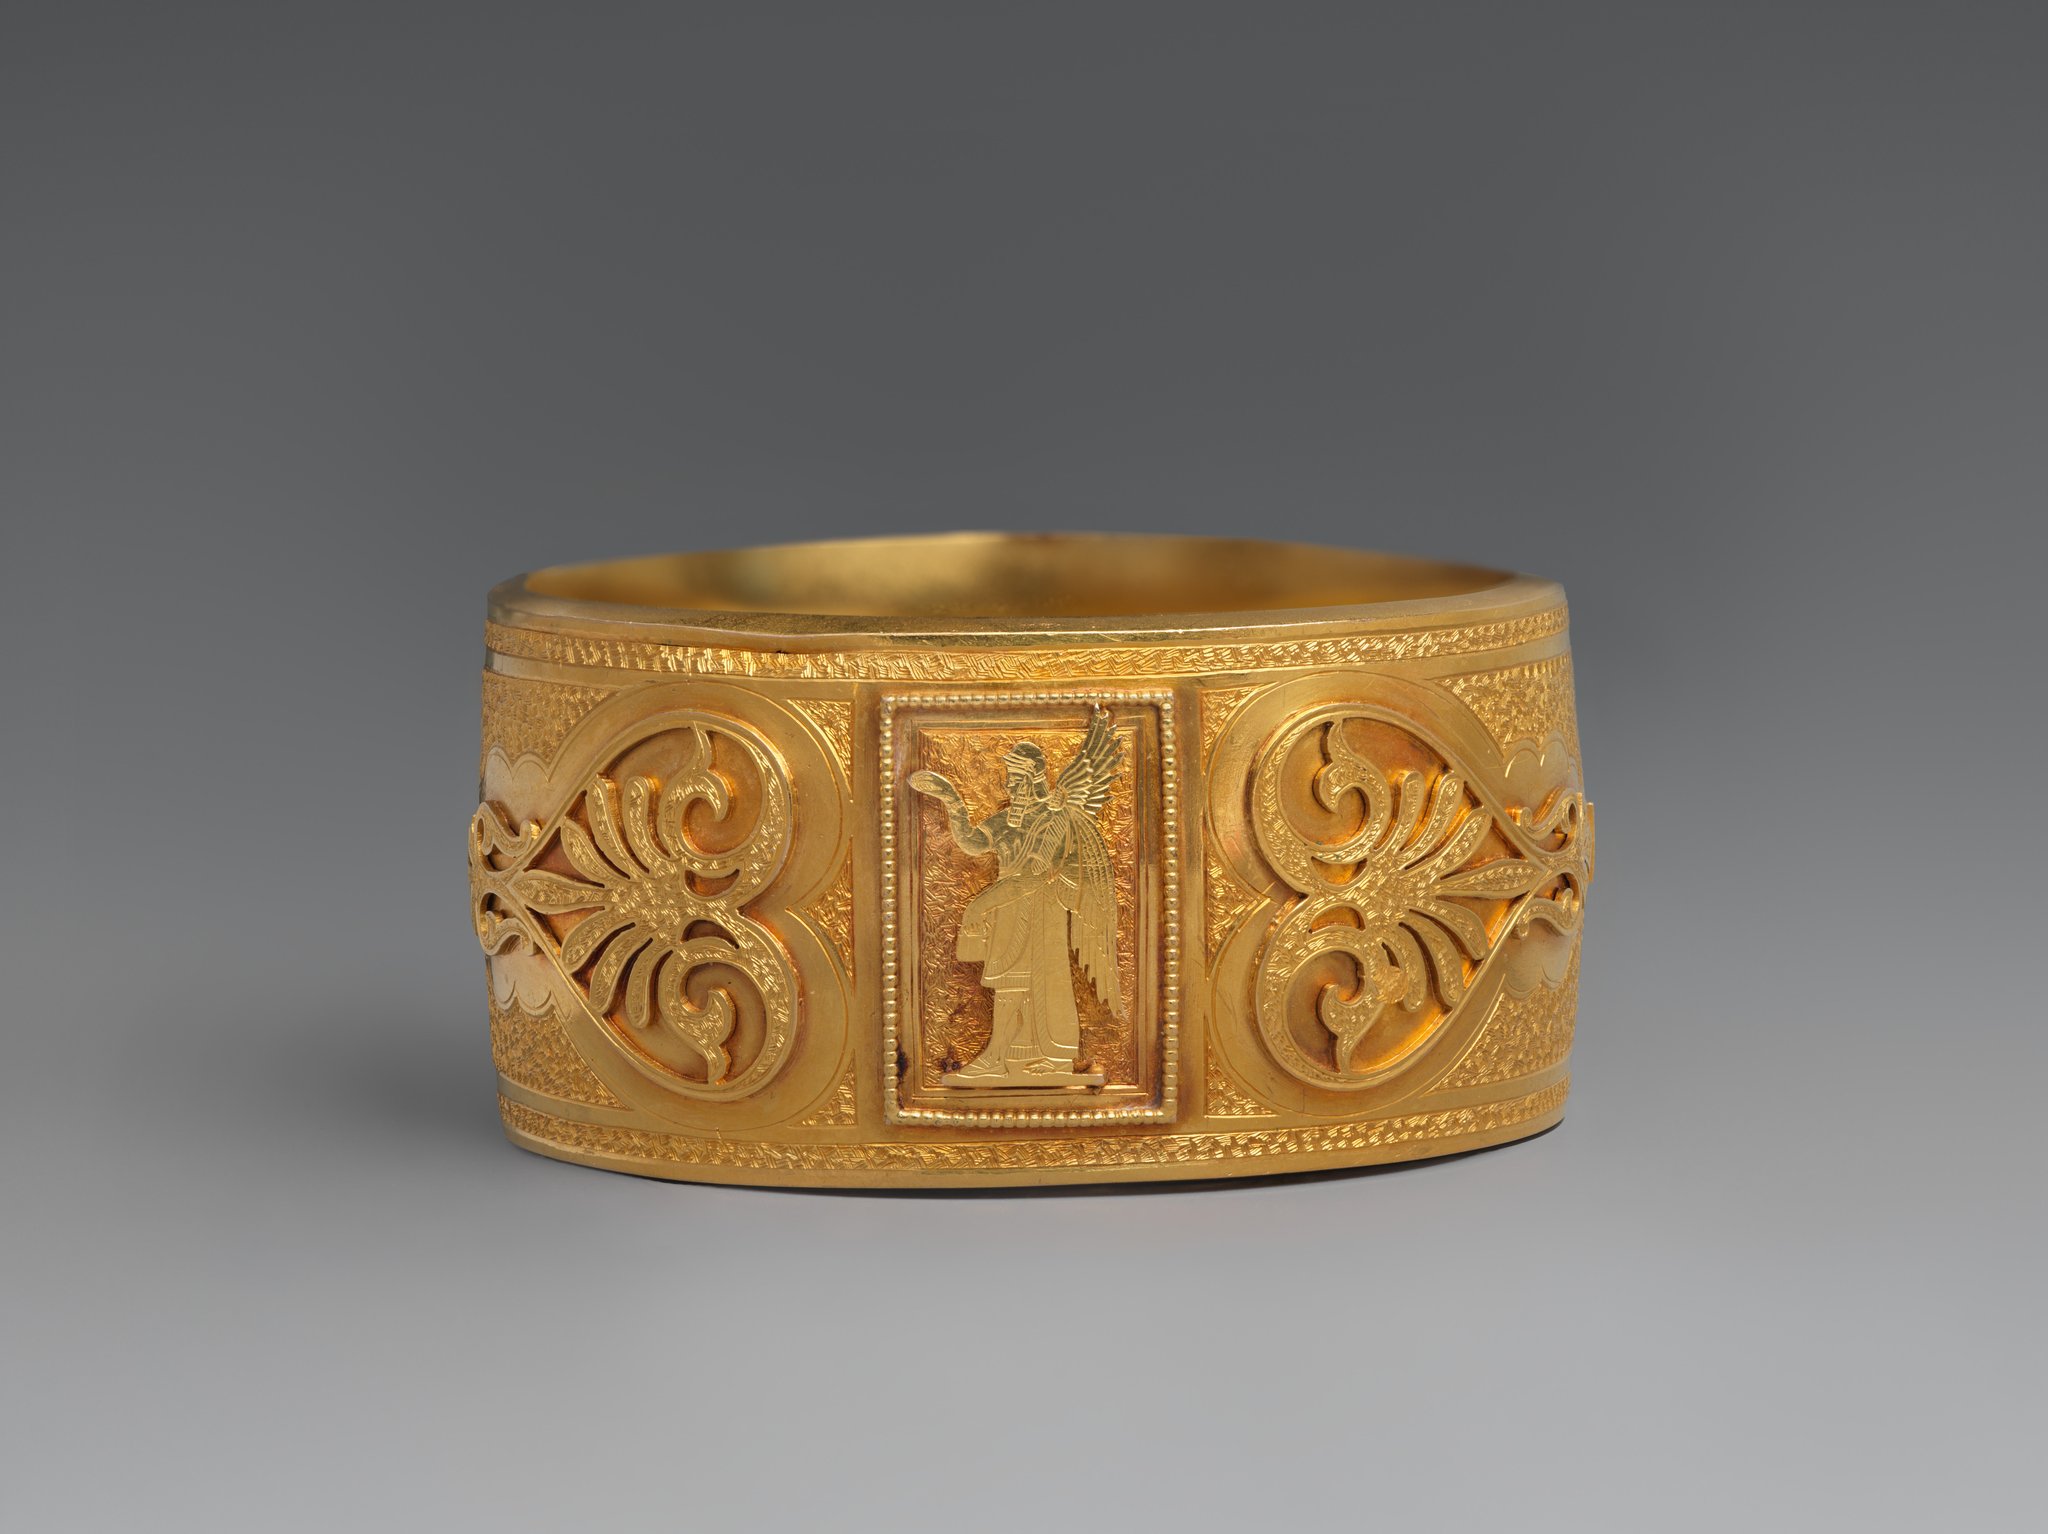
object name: hinged bracelet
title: Bracelet with Assyrian-inspired design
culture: british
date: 1870-1880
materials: gold